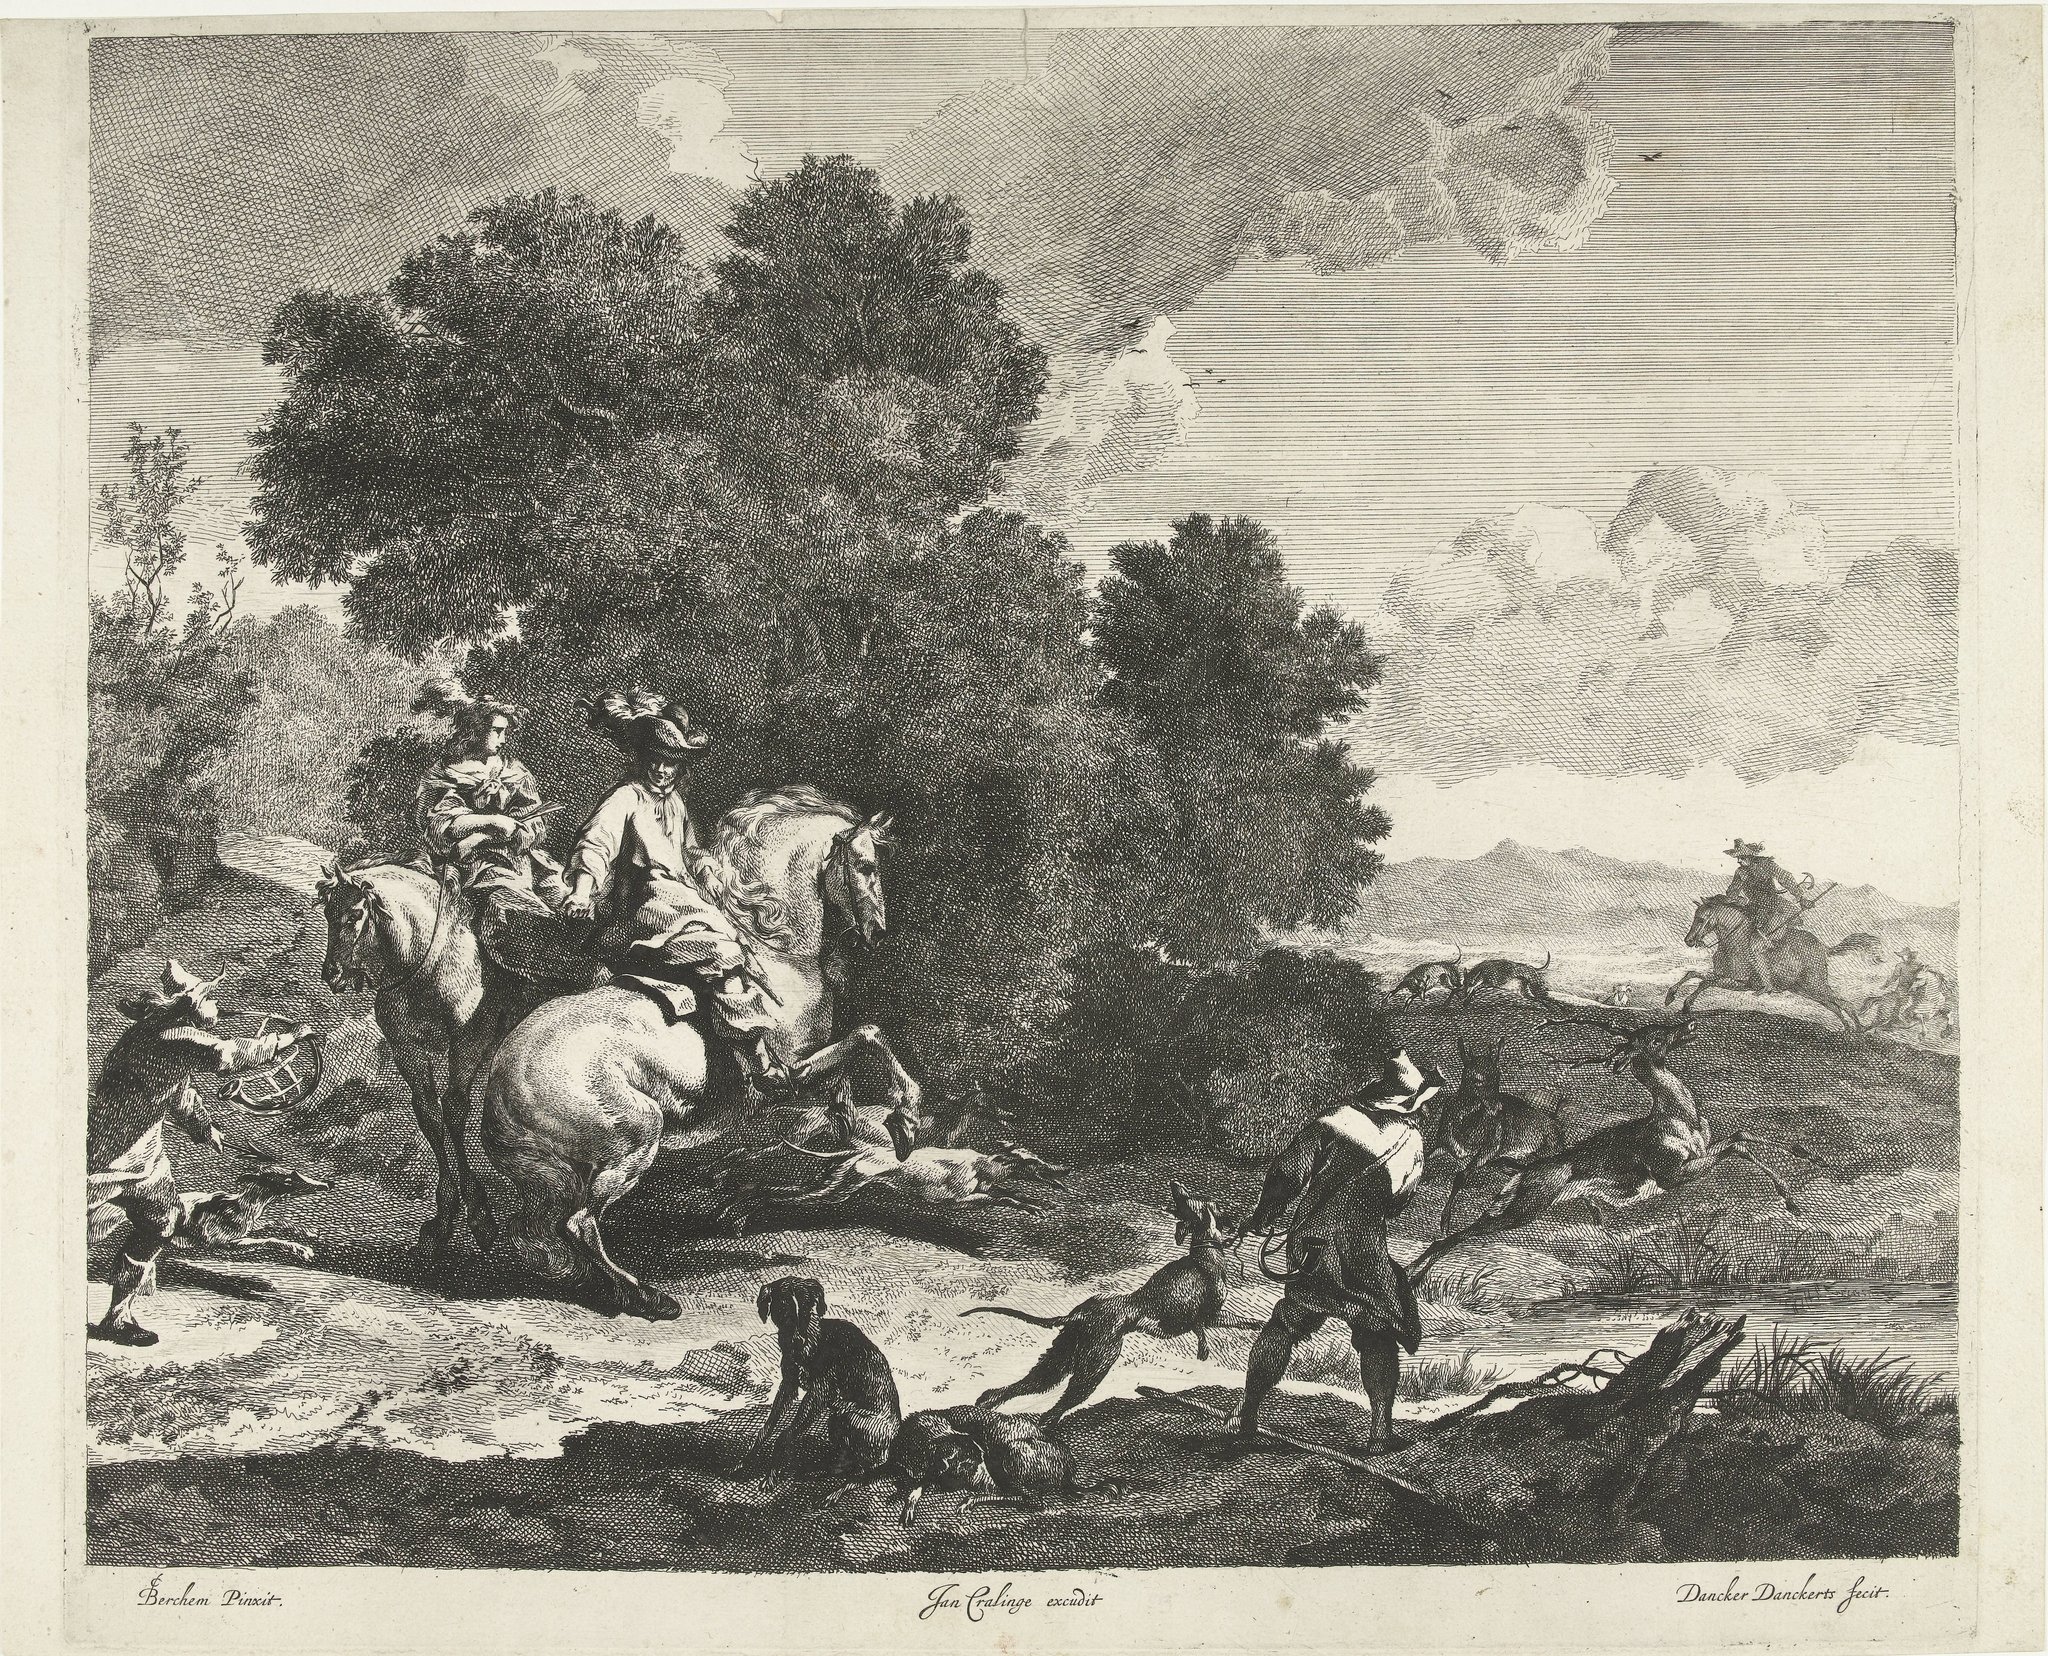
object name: print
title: Hertenjacht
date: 1633-1666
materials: paper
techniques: etching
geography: amsterdam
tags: stag-hunting, hunting dogs, hoofed animals: stag, hunters hunting (n.b.: in 1988-1990 this notation denoted the concept of 43c11421 'hunters resting during the hunt')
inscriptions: collector's mark: Lugt 240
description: Herten worden opgejaagd door jachthonden terwijl een man op een jachthoorn blaast en een rijk gekleed stel te paard toekijkt.